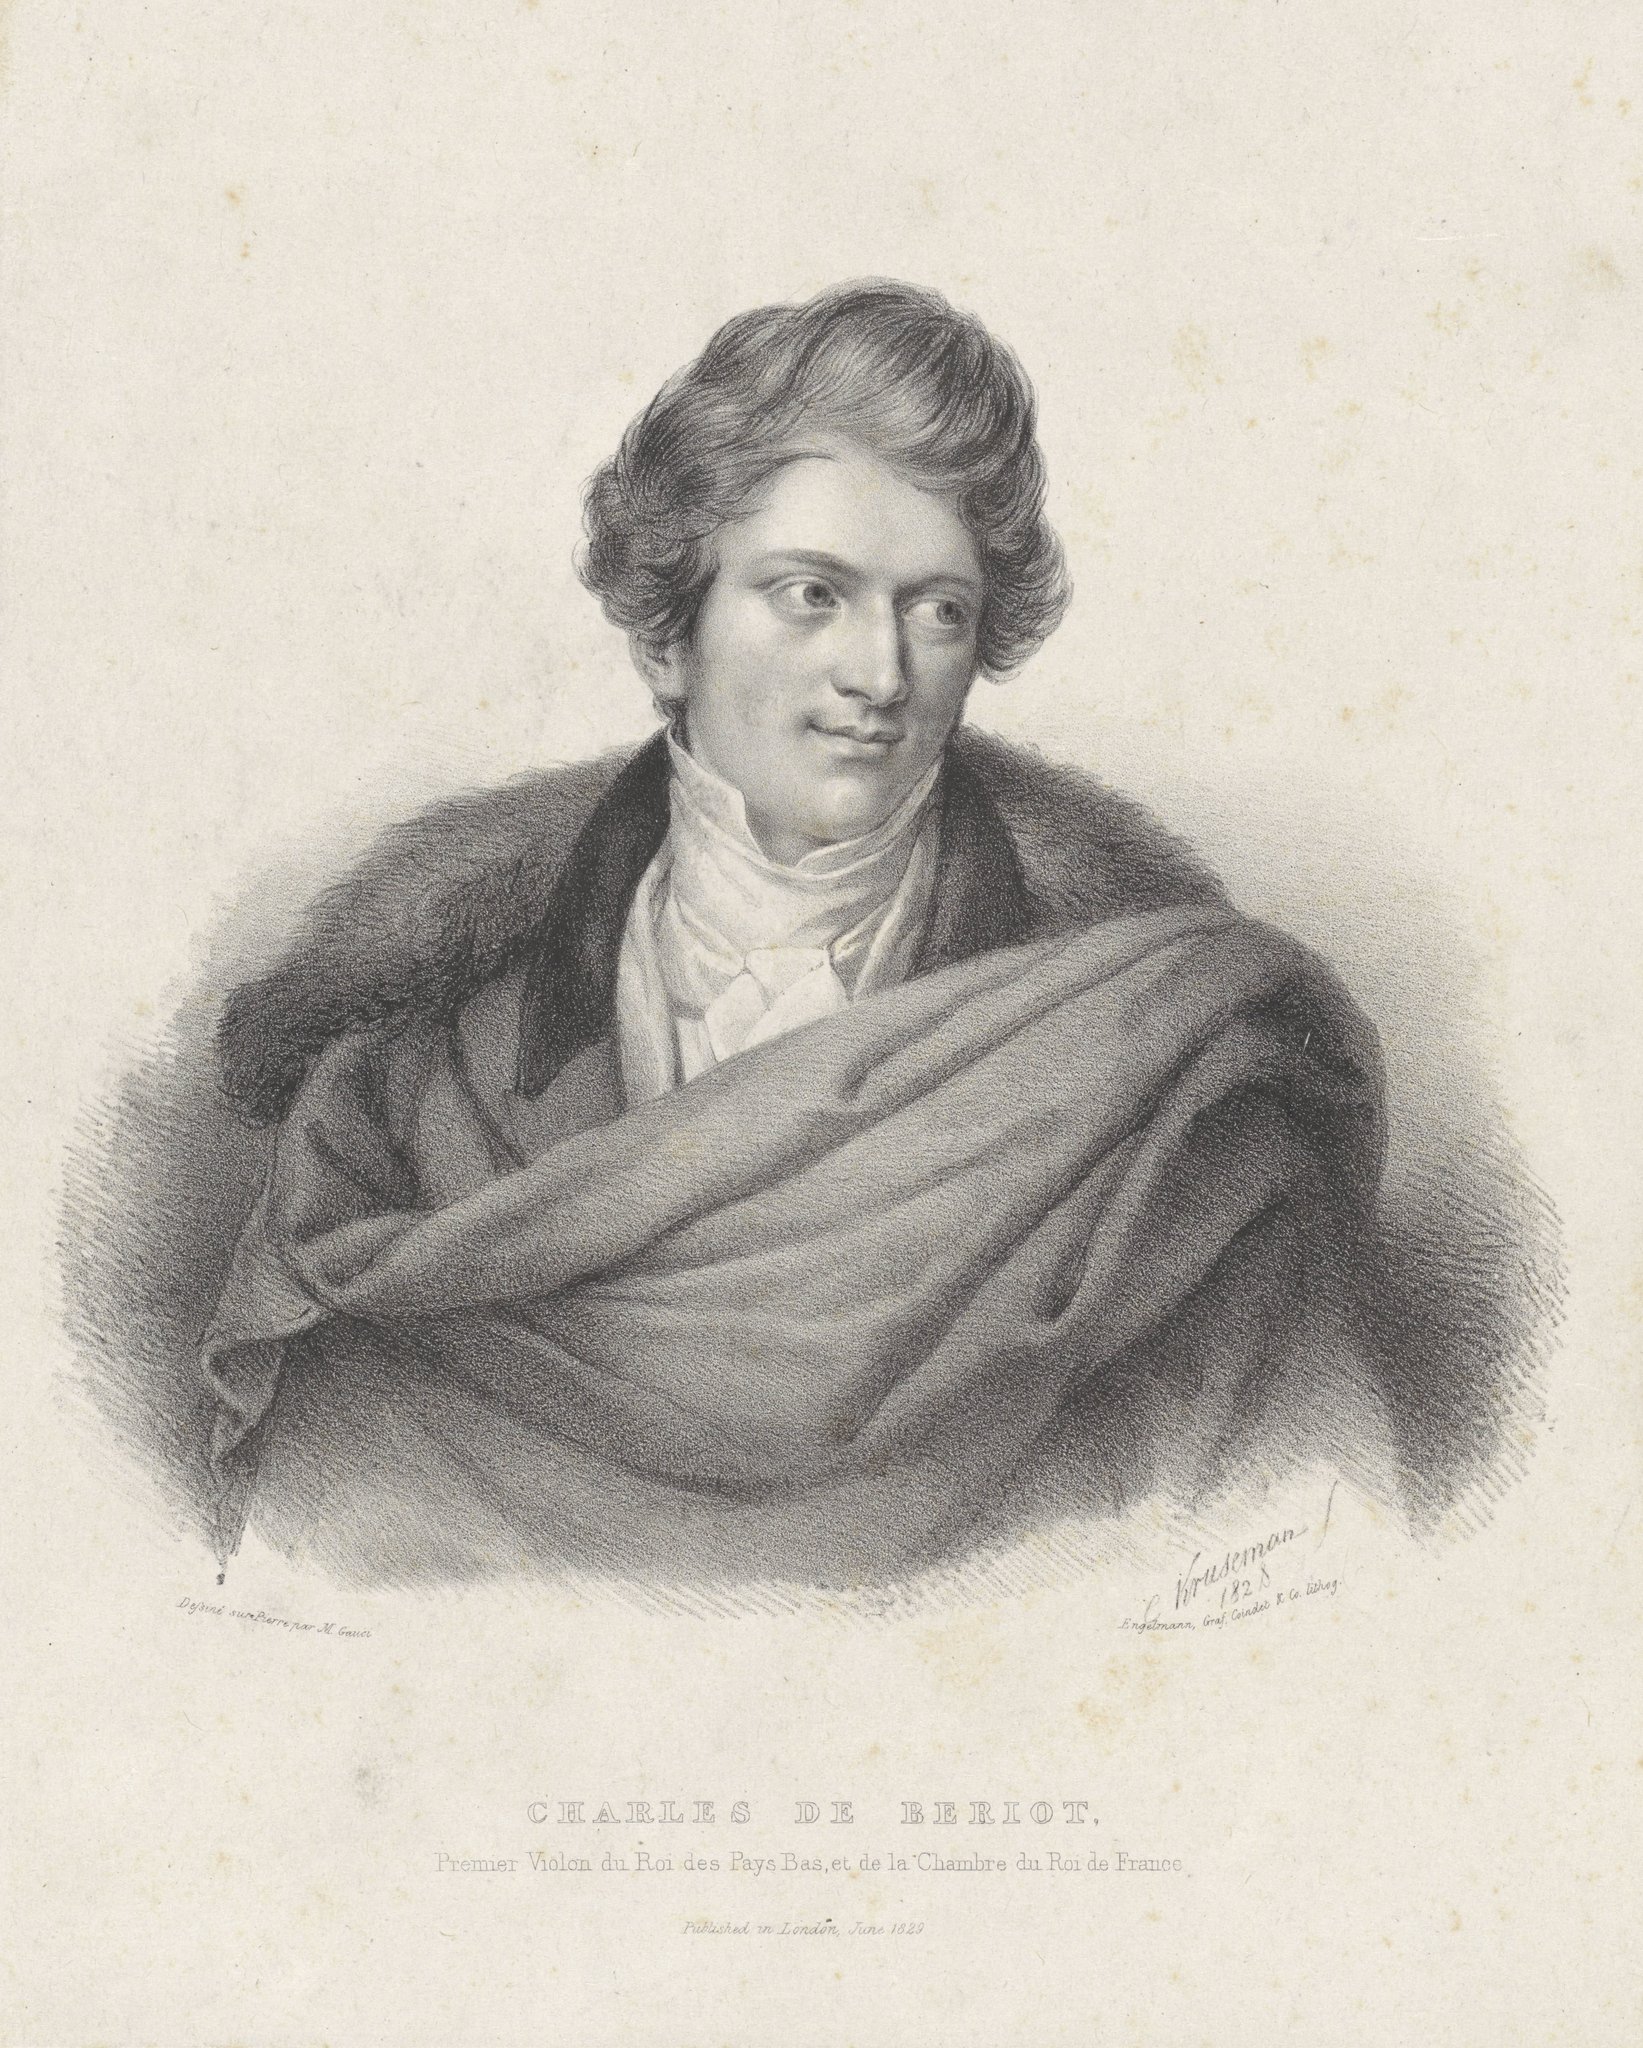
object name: print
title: Portret van de violist Charles de Beriot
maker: maxim gauci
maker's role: print maker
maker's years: 1774-1854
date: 1806-1829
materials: paper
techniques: lithograph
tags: louvain, historical persons